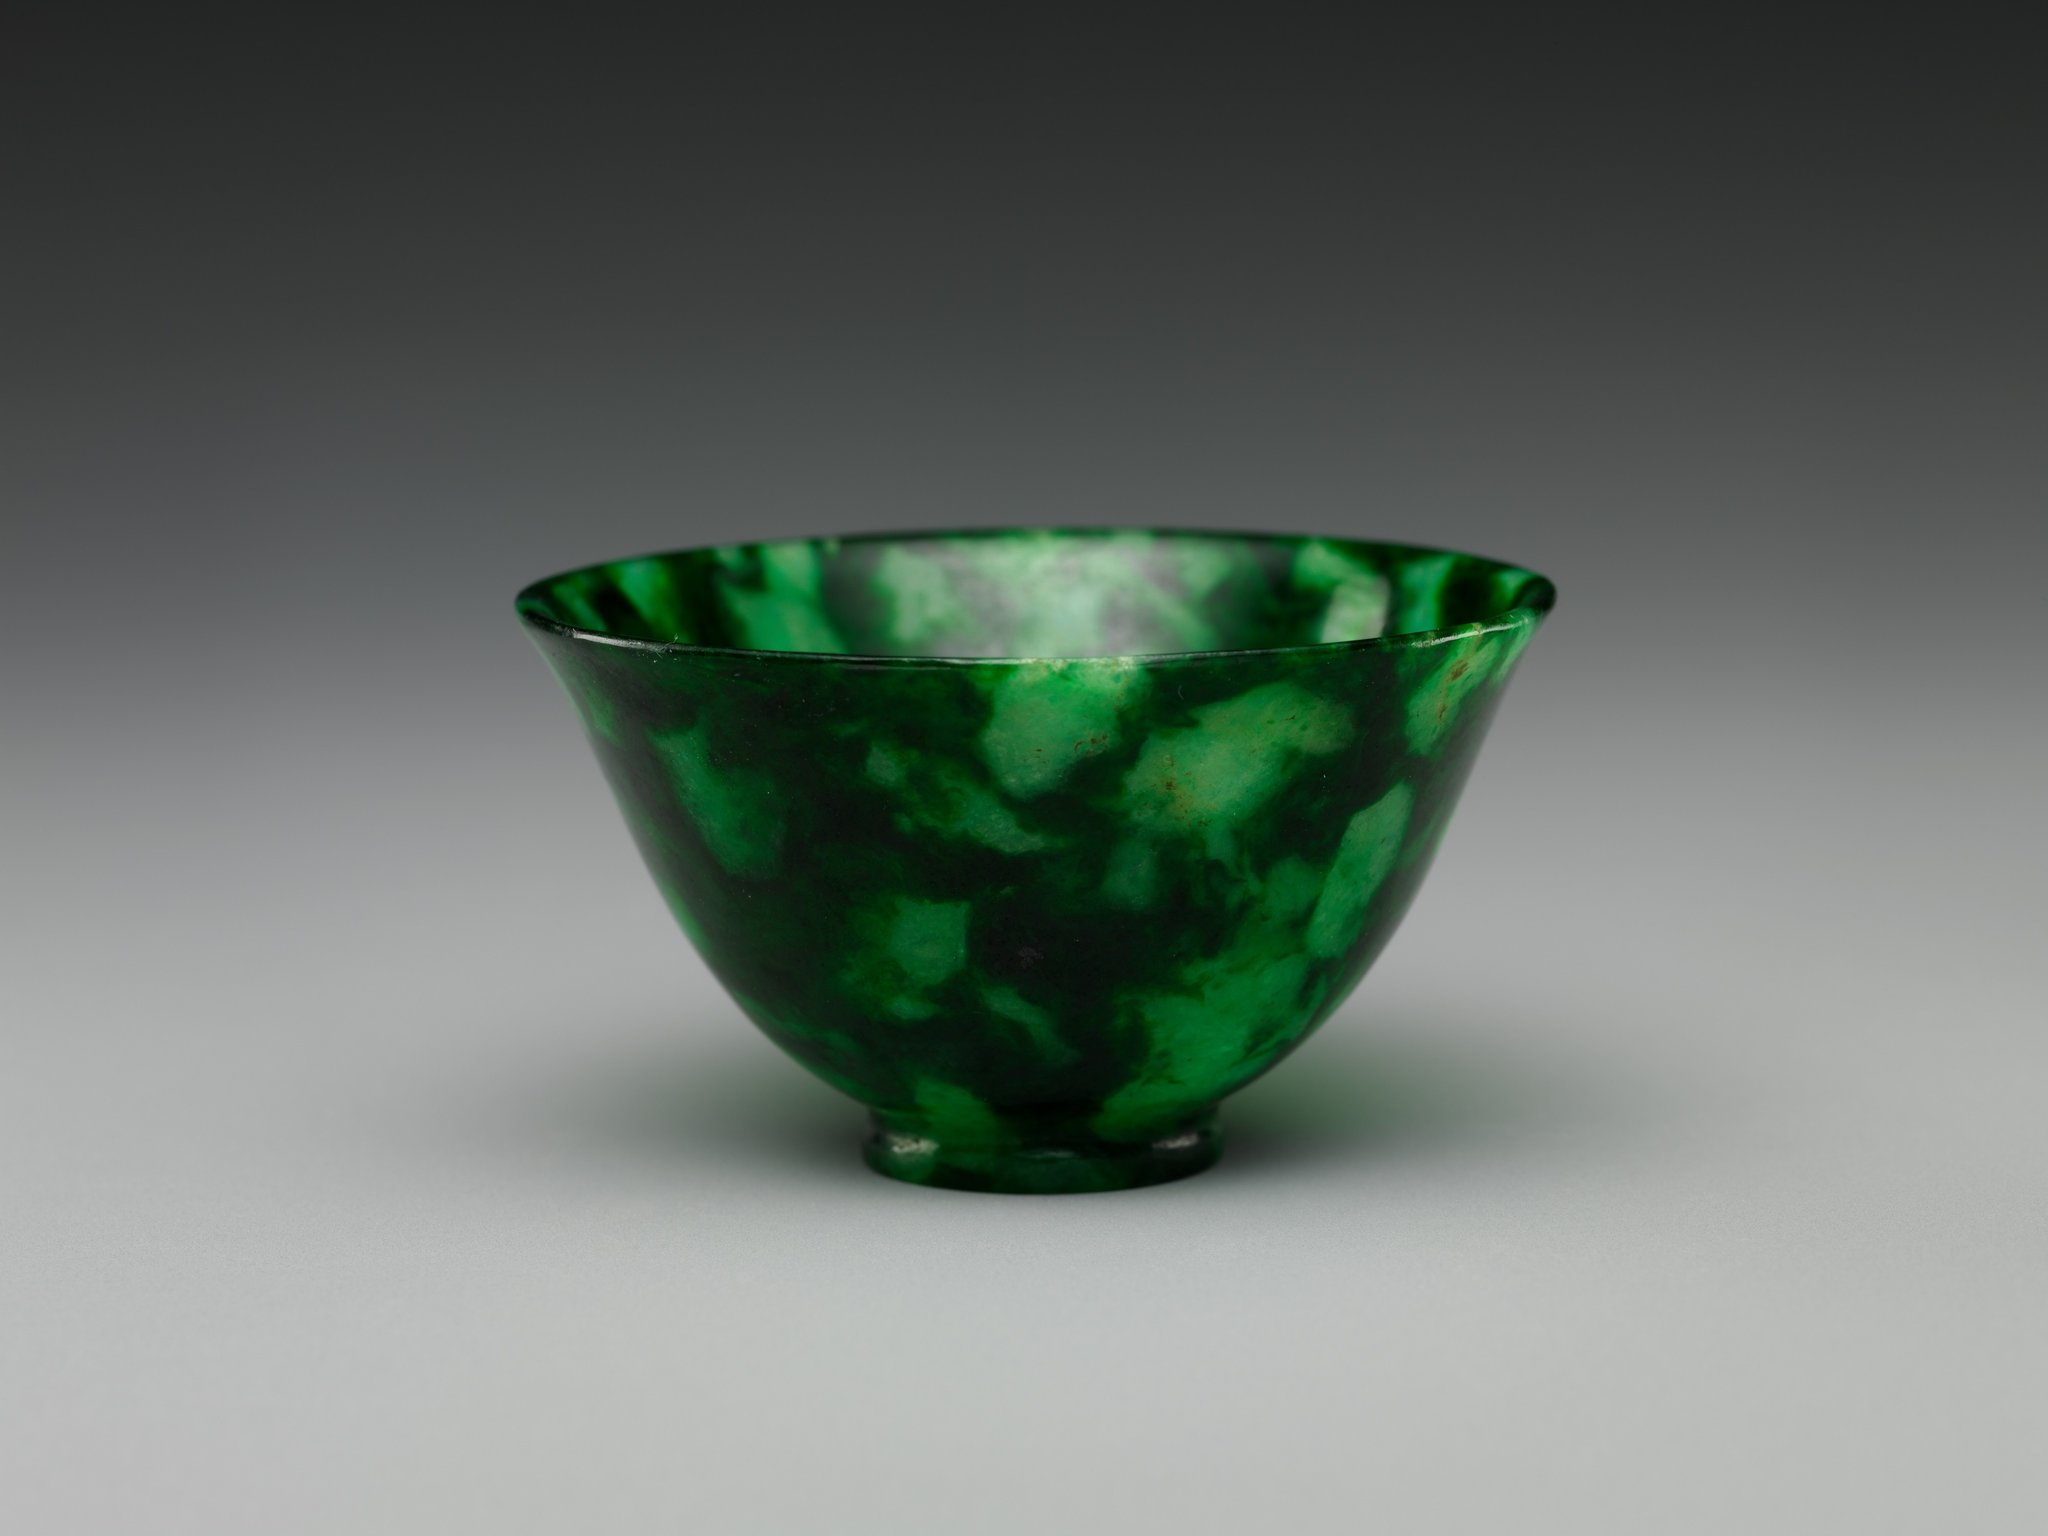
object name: cup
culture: chinese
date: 1801-1900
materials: jade